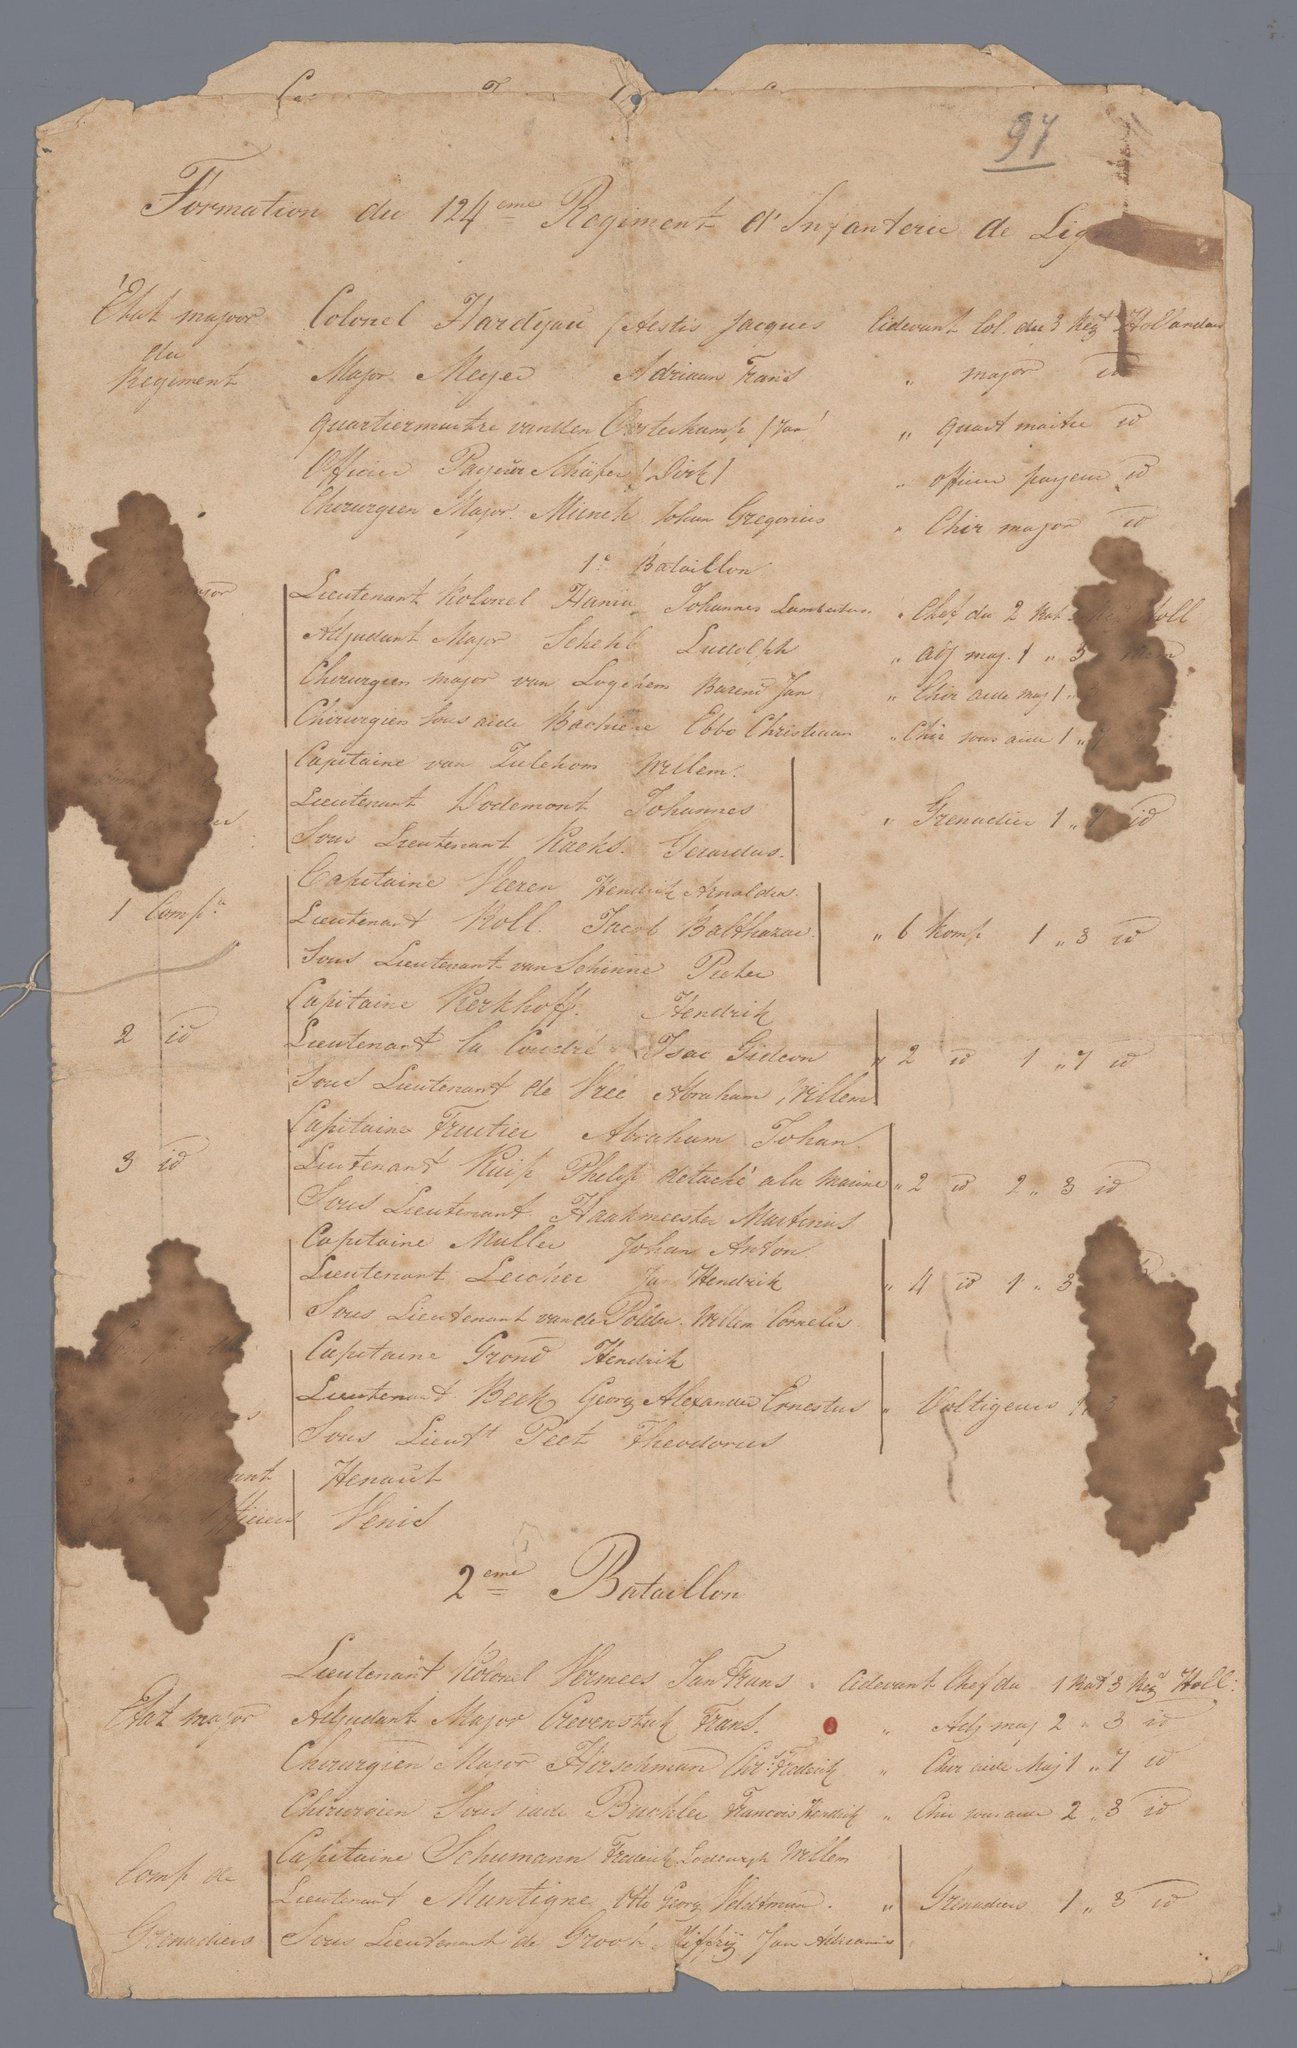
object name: document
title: Formation du 124me Regiment d'Infanterie de Ligne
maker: Anonymous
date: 1812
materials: ink, paper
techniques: sewing, writing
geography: netherlands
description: Namenlijst: twee met touwtjes samengebonden vellen papier, elk aan beide zijden beschreven, officieren van het 124e reg. inf.